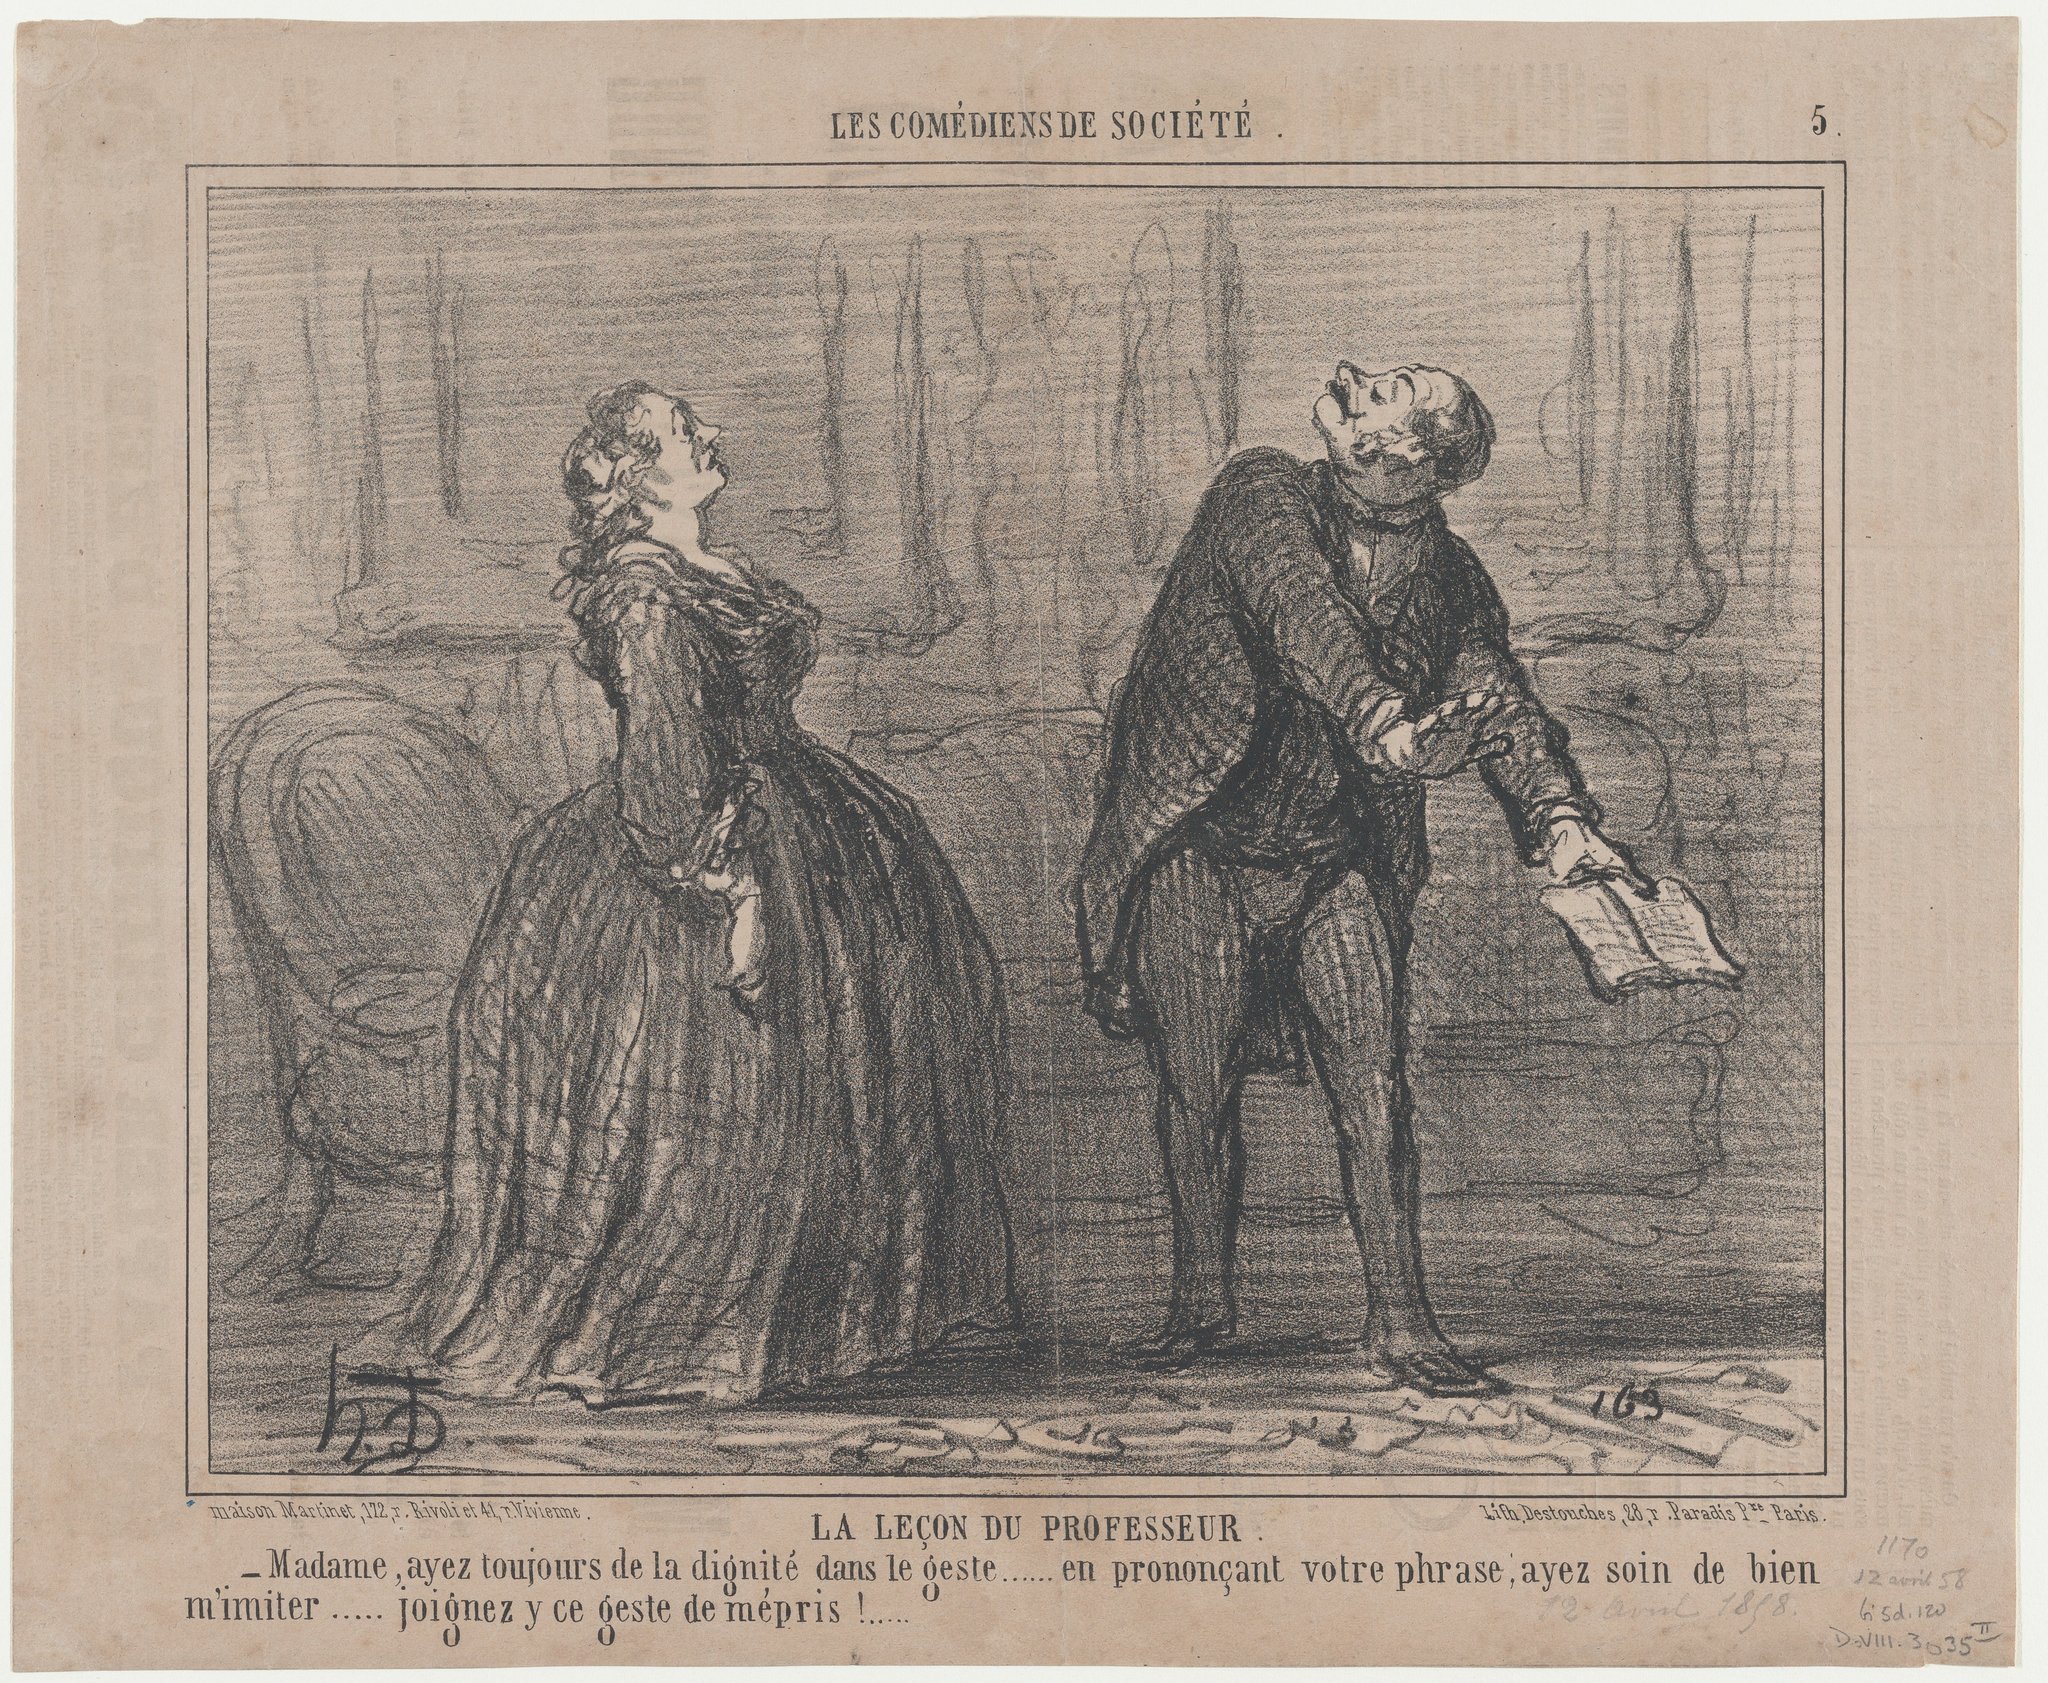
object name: print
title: Le leçon du professeur, from Les Comédiens de Société, published in Le Charivari, April 12, 1858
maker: honoré daumier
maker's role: artist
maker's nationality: french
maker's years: 1808-1879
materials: paper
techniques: lithograph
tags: men,women